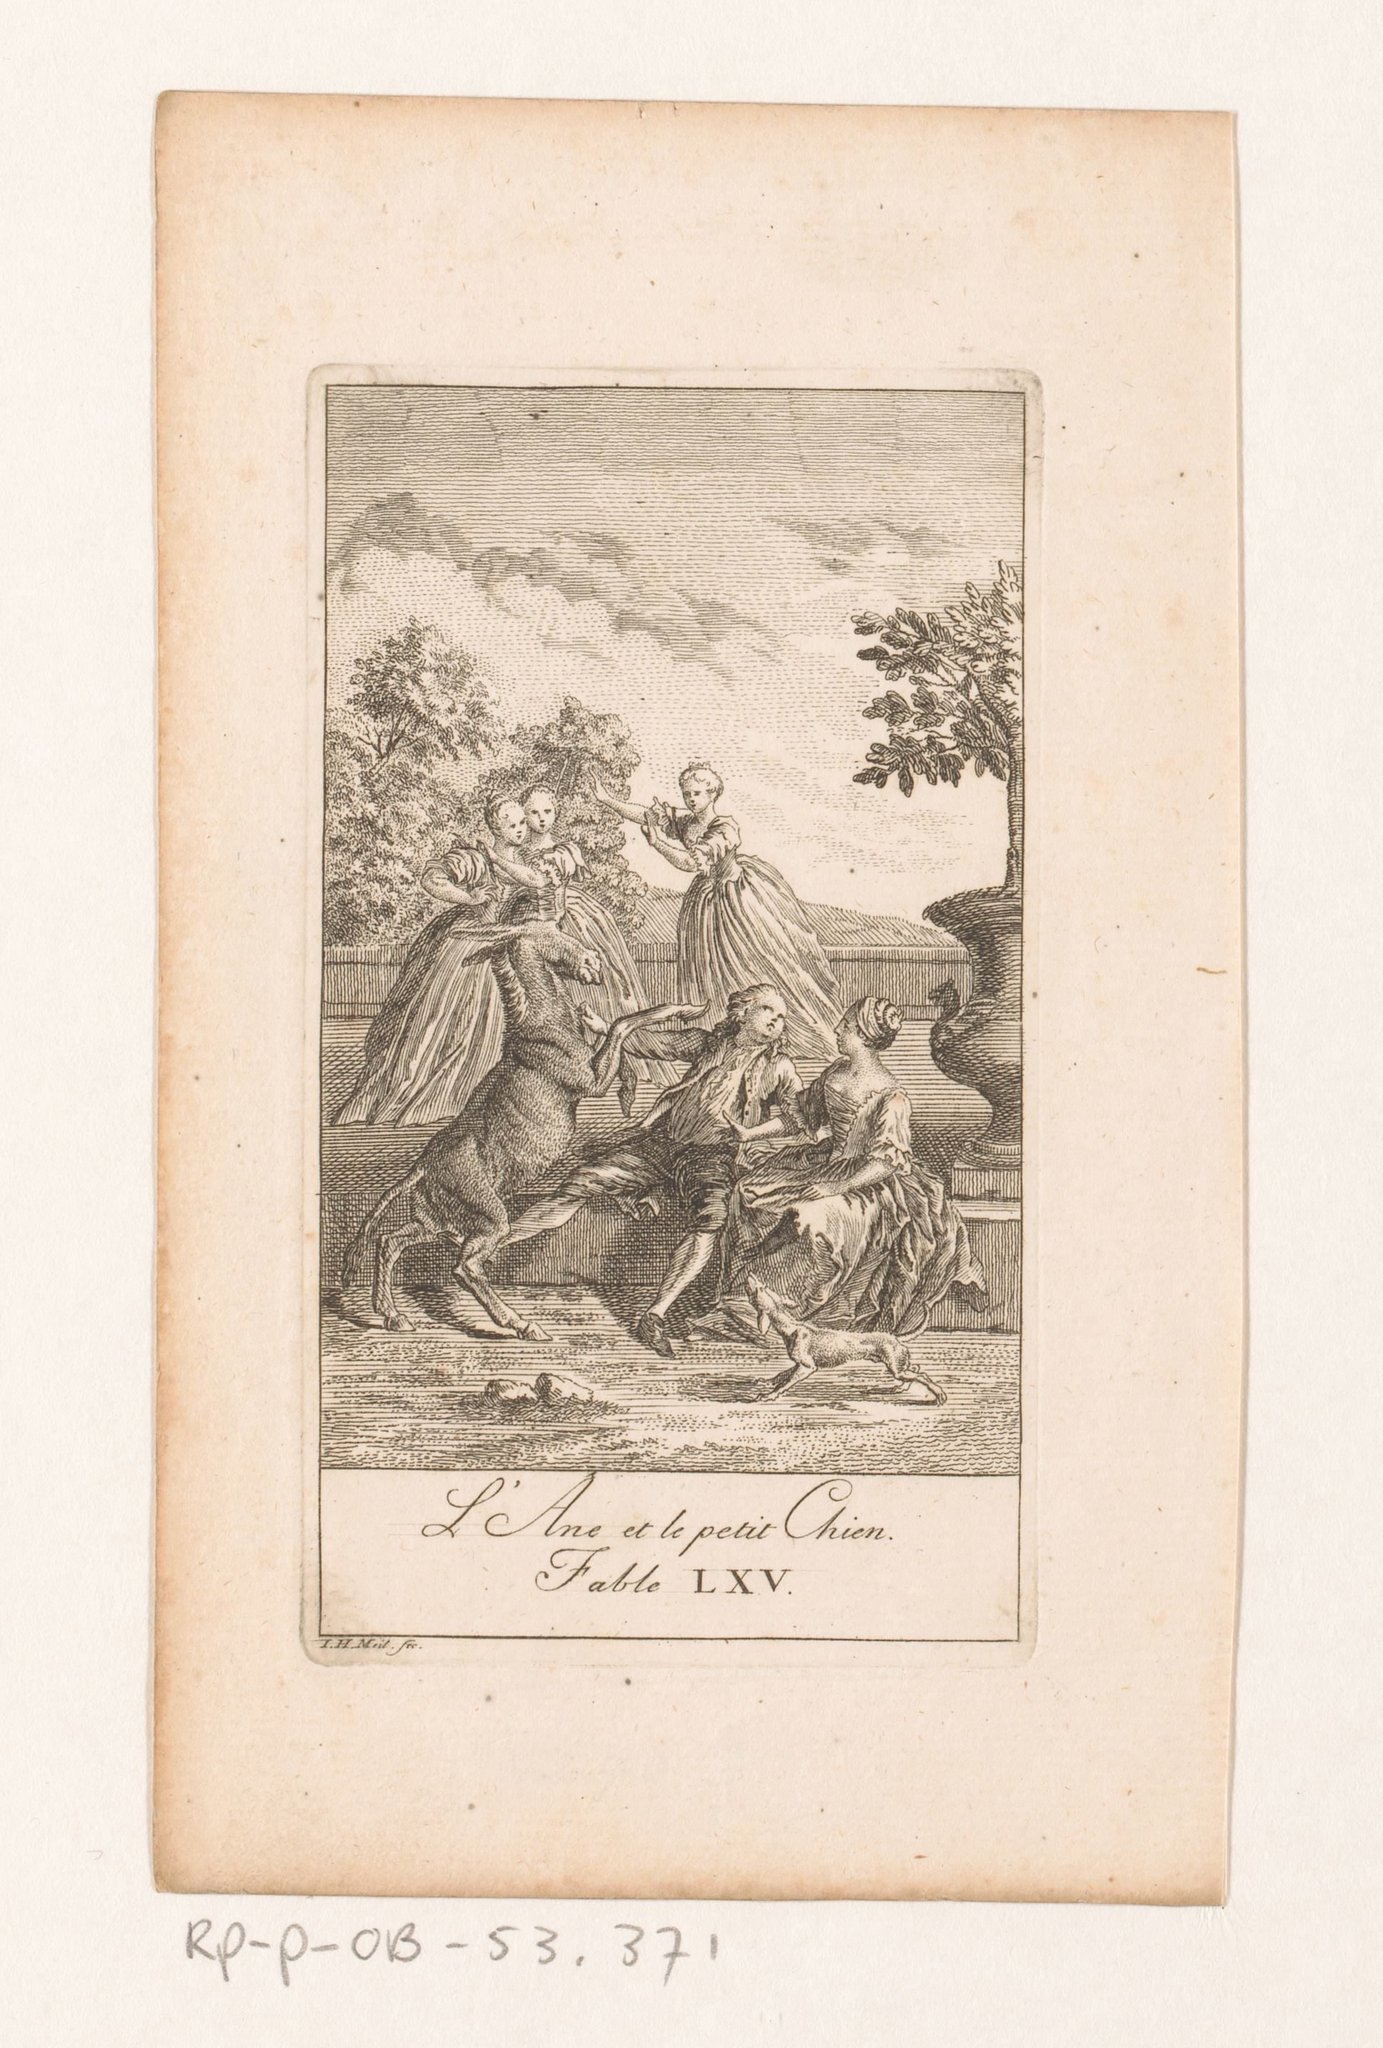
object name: print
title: L'ane et le petit chien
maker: johann heinrich meil (der ältere)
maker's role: print maker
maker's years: 1730-1820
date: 1758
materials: paper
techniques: etching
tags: fables of lafontaine : use 85(...), ass, donkey, dog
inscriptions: collector's mark: Lugt 2228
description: Illustratie uit: Fontaine, J. de la. Fables choisies, mises en vers. Dl. 2. Dresden & Leipzig: George Conrad Walther, 1758.